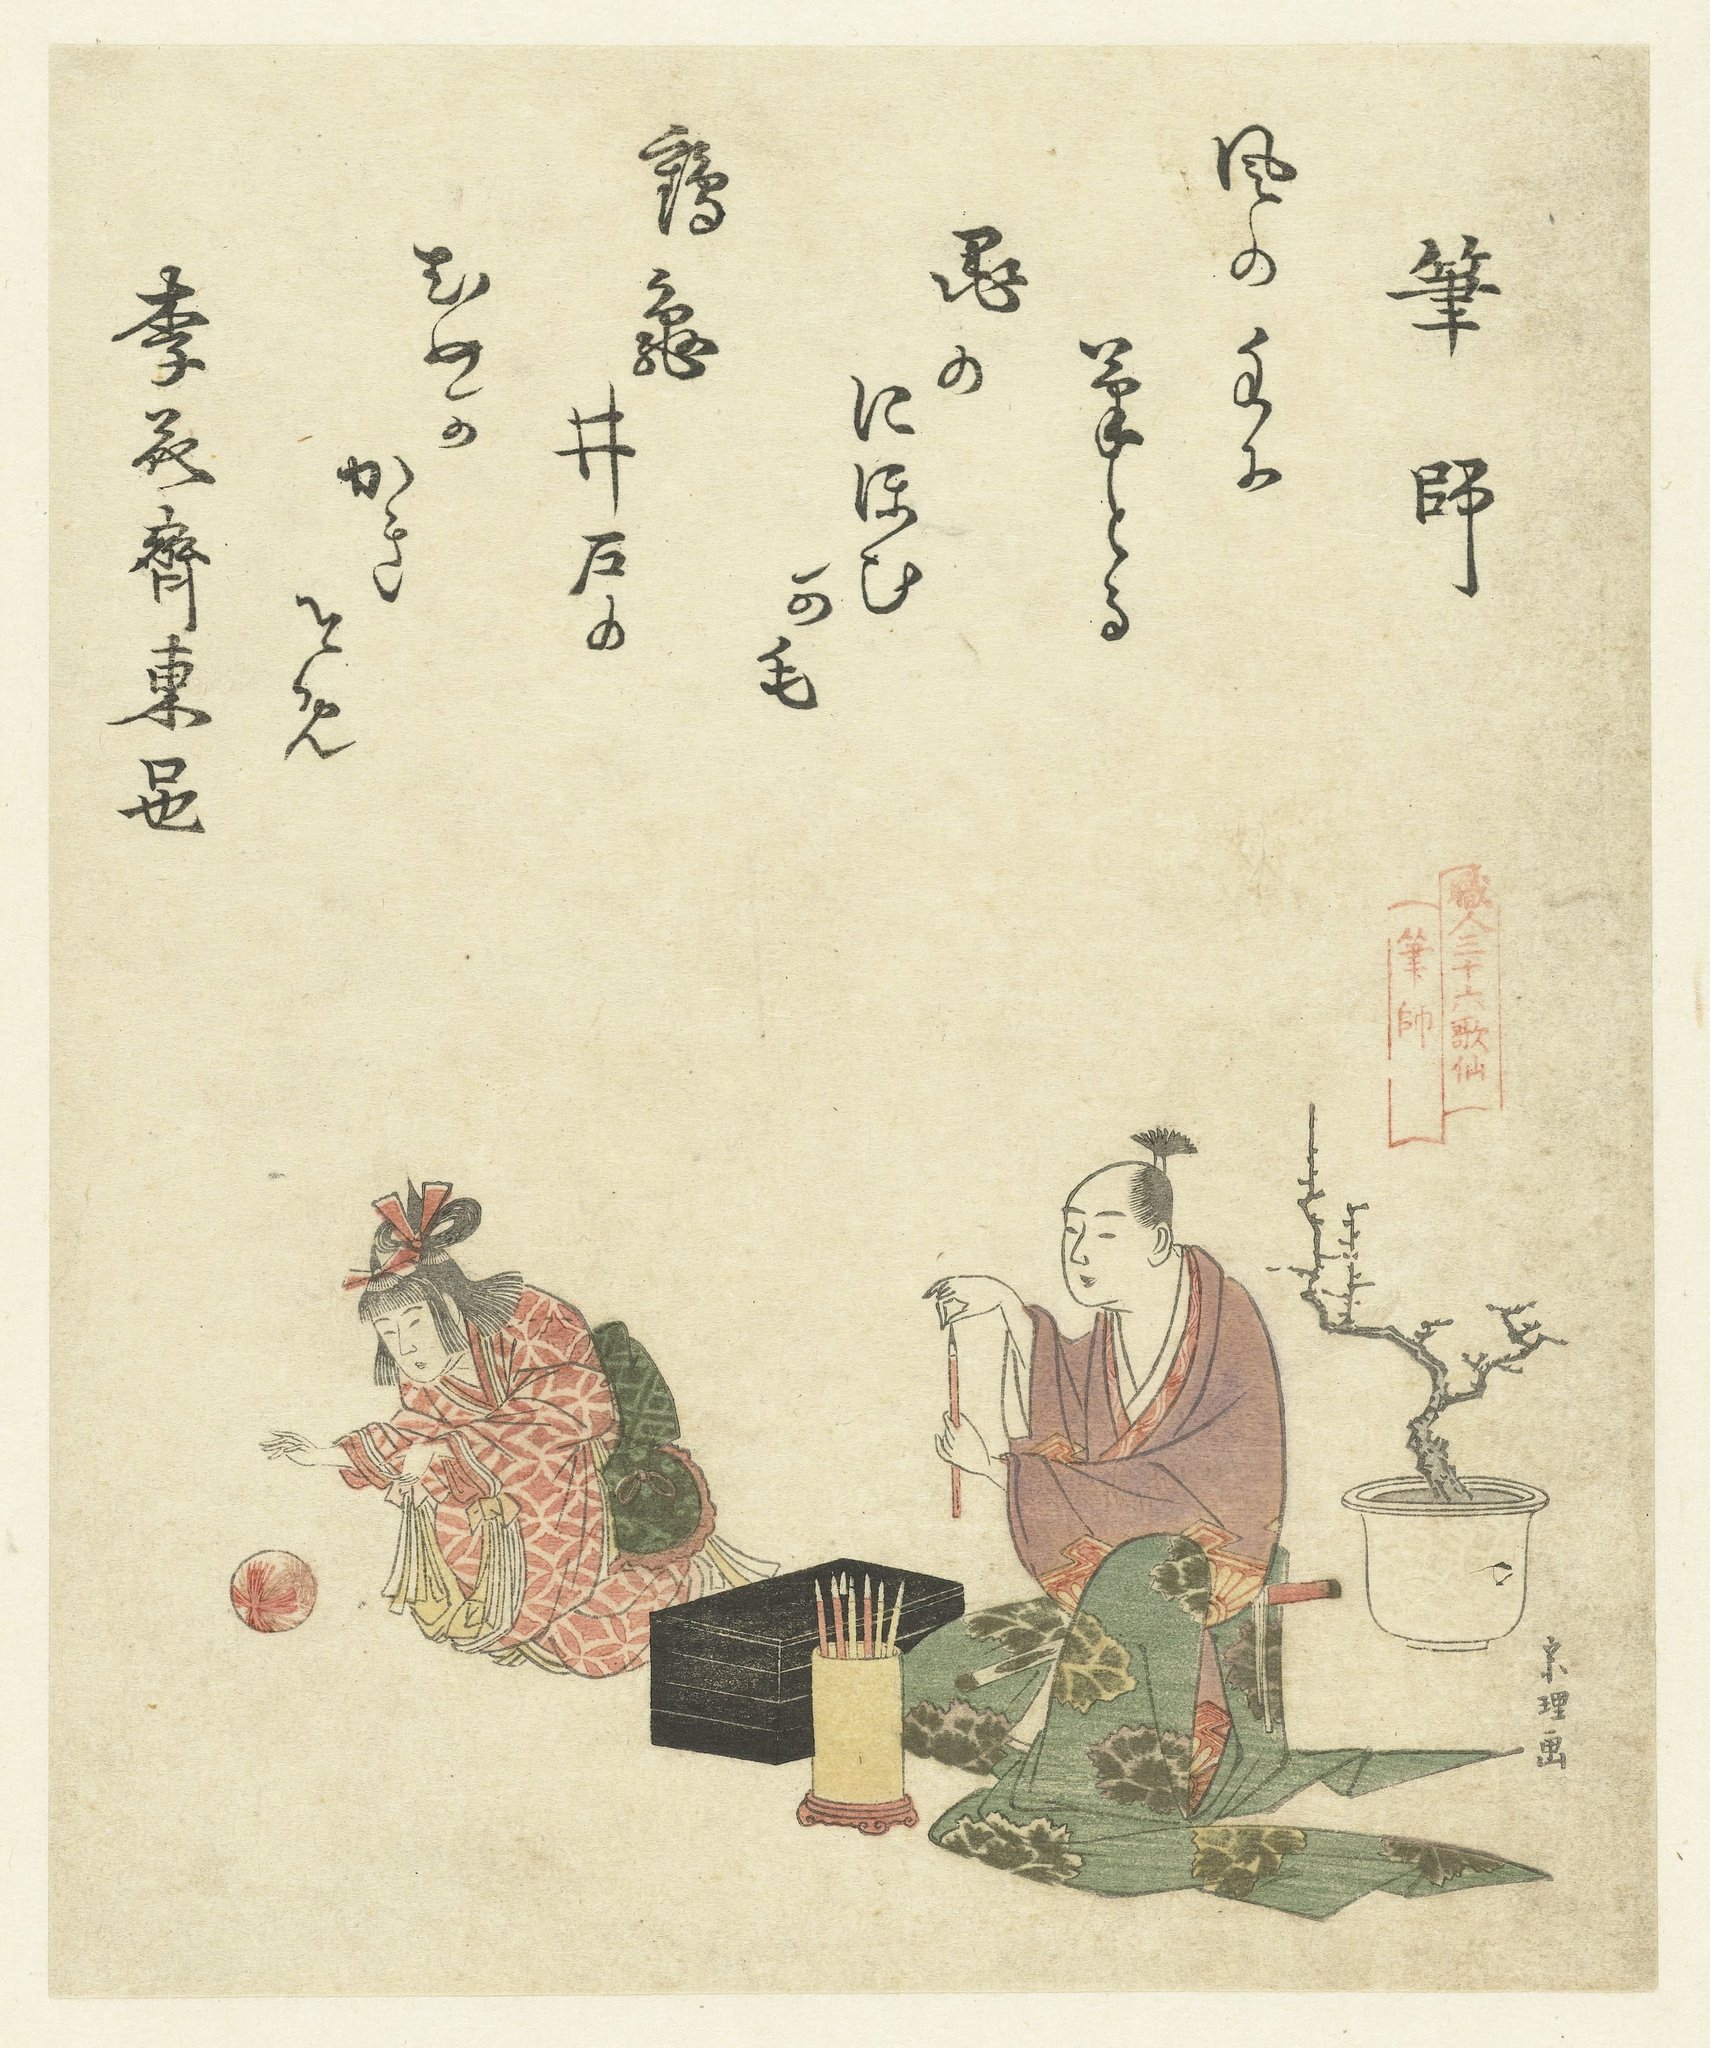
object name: print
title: A Brush-maker at Work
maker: hishikawa sôri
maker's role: print maker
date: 1803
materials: paper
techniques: blind stamped, woodcut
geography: japan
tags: handicrafts ~ other plant material, writing tools, brushes ~ implements of painter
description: Een surimono is een luxe uitgevoerde prent waarop beeld met één of meerdere gedichten gecombineerd is. Bij het drukken van een surimono werd vaak gebruik gemaakt van dikker papier, blinddruk en metaal pigmenten, zoals koper- en zilverpoeder. De prenten werden vaak in opdracht van dichters gemaakt en als exclusief geschenk aan vrienden en relaties gegeven.